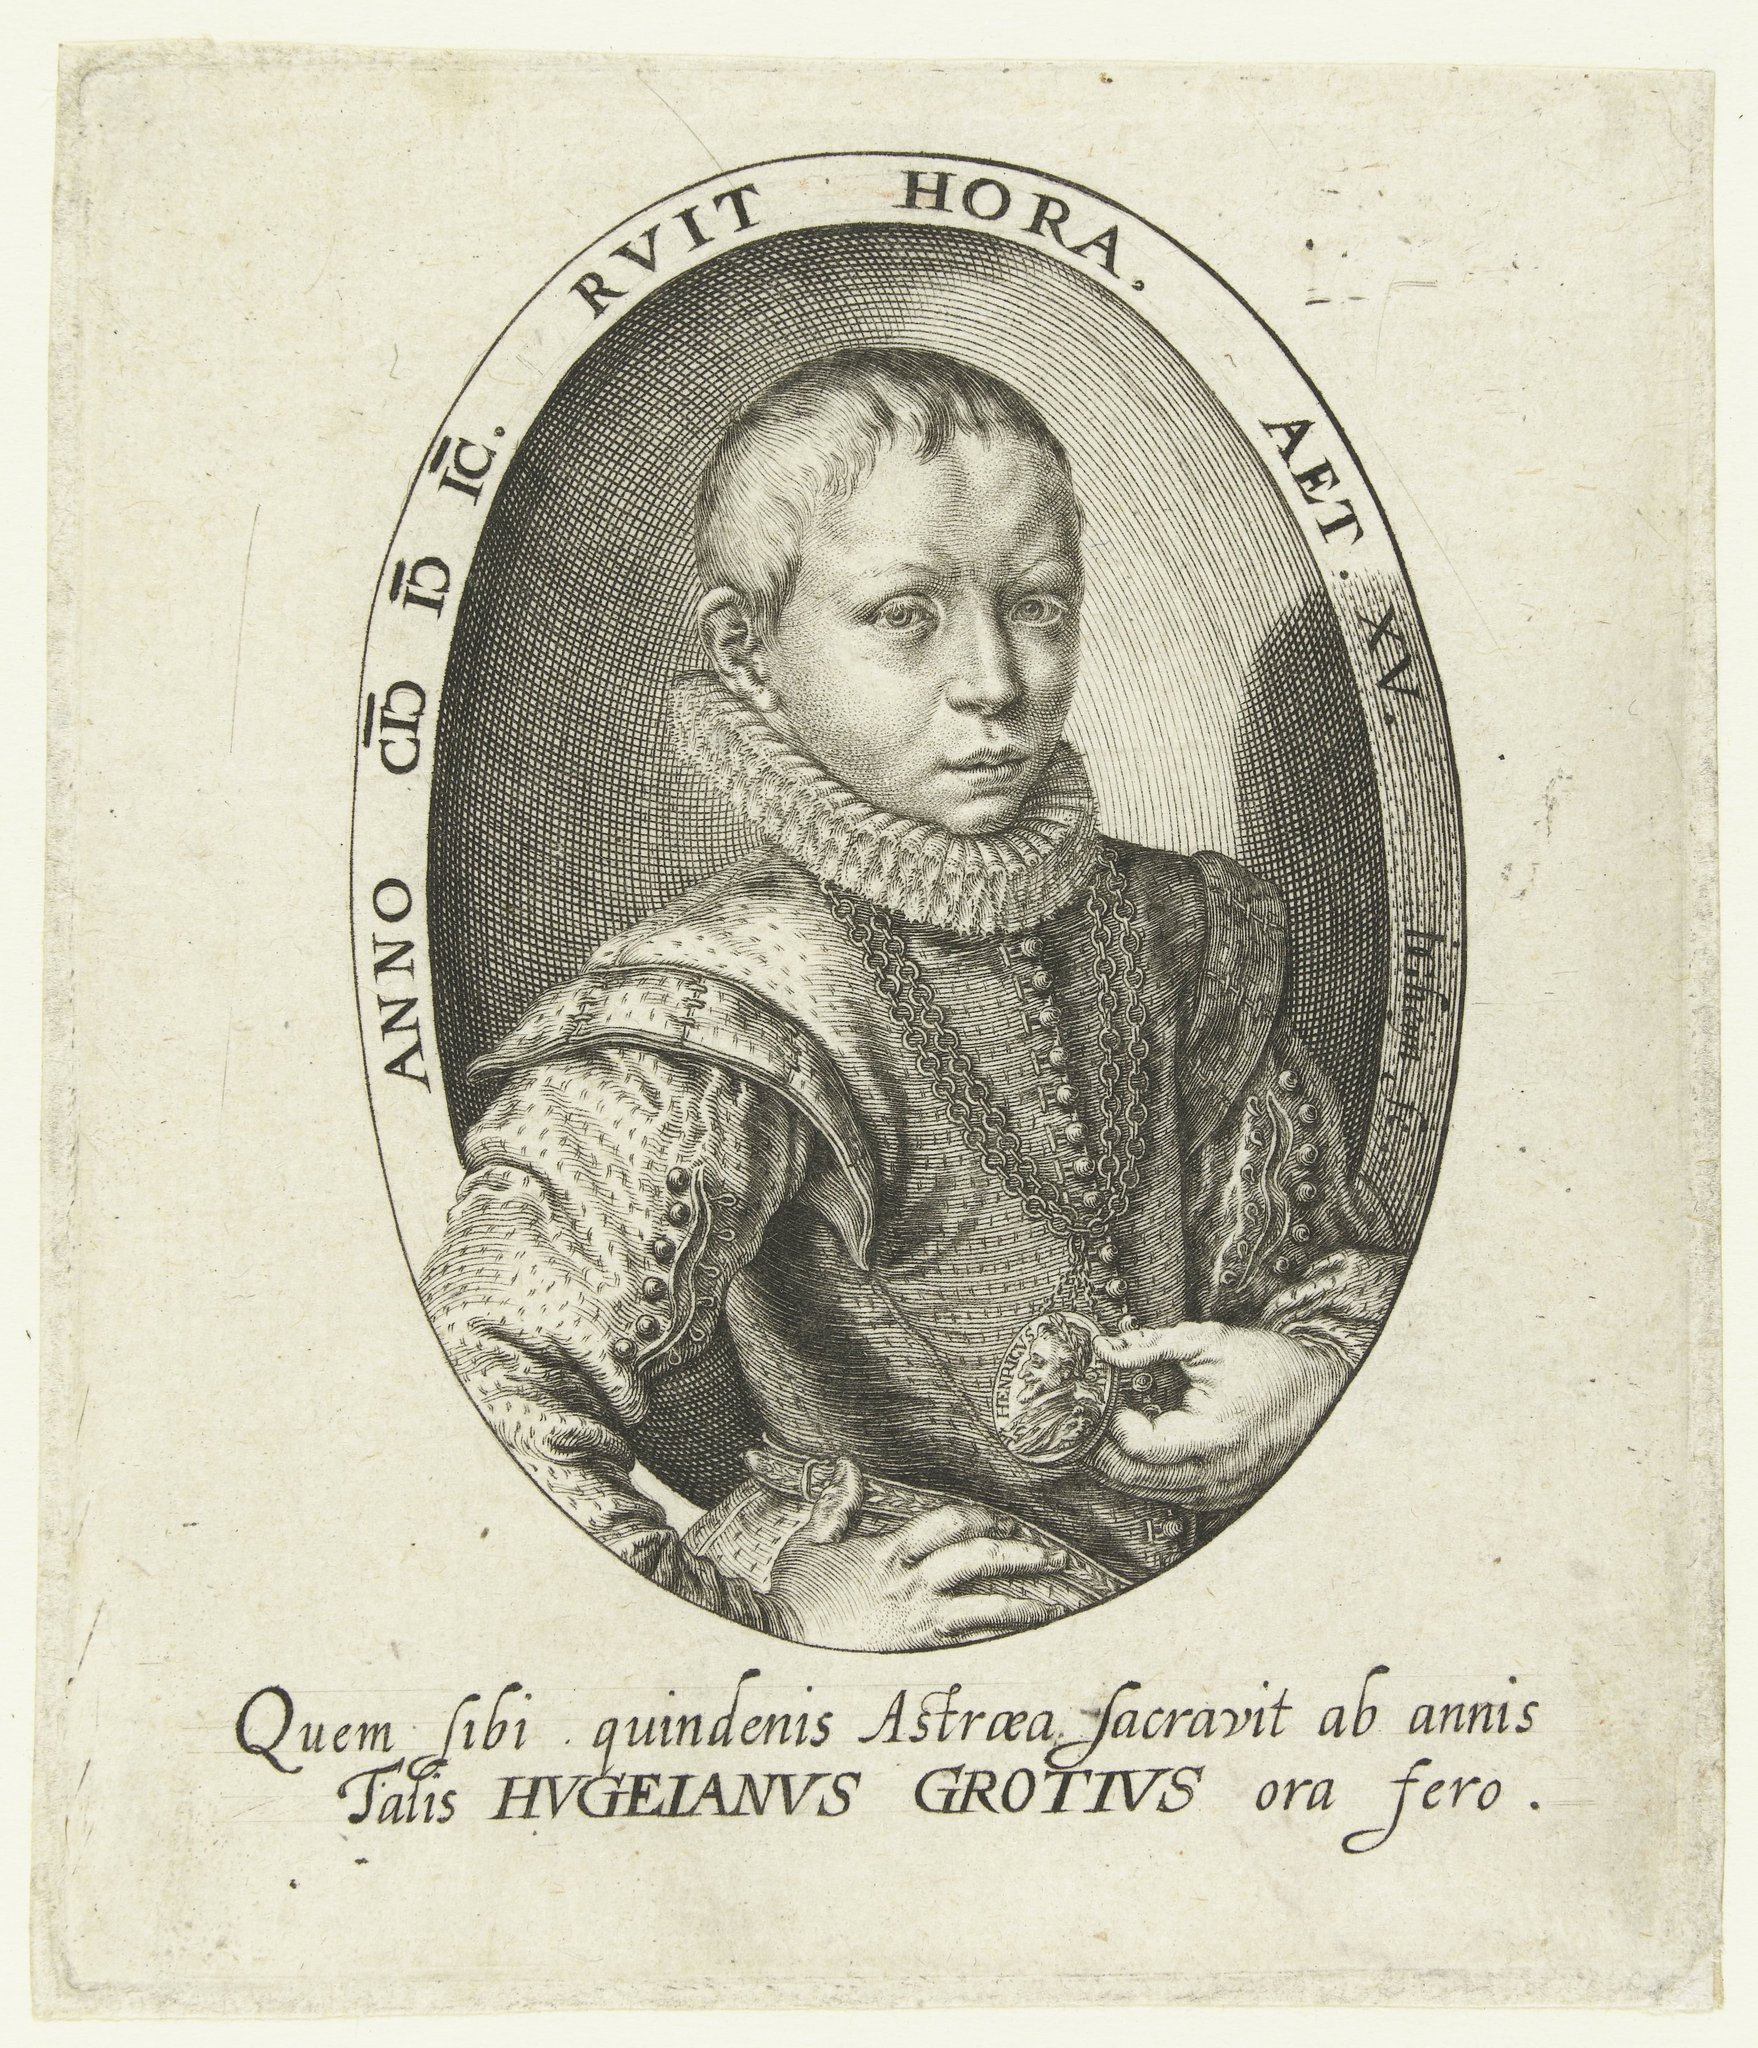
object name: print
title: Portret van Hugo de Groot op 15-jarige leeftijd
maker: jacques de gheyn (ii)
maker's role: painter, print maker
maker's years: 1565-1629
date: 1599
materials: paper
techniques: engraving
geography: netherlands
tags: delft, hugo de groot, aspects of science in general (+ child as scholar or scientist), neck-gear ~ clothing (ruff) (+ boys' clothes), historical persons, professor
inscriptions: collector's mark: Lugt 240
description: Buste van Hugo de Groot als 15-jarige jongeman, min of meer op de rechterzijde gezien, in ovaal. Het wonderkind Hugo de Groot had in 1599 (datering prent) al een universitaire studie achter de rug: tijdens zijn verblijf in Frankrijk in 1598 was hij in de rechten gepromoveerd. Koning Hendrik IV schonk hem bij deze gelegenheid een medaillon, dat hij hier in de linkerhand houdt. Om de voorstelling een regel Latijnse tekst, onder de voorstelling twee regels Latijnse tekst.